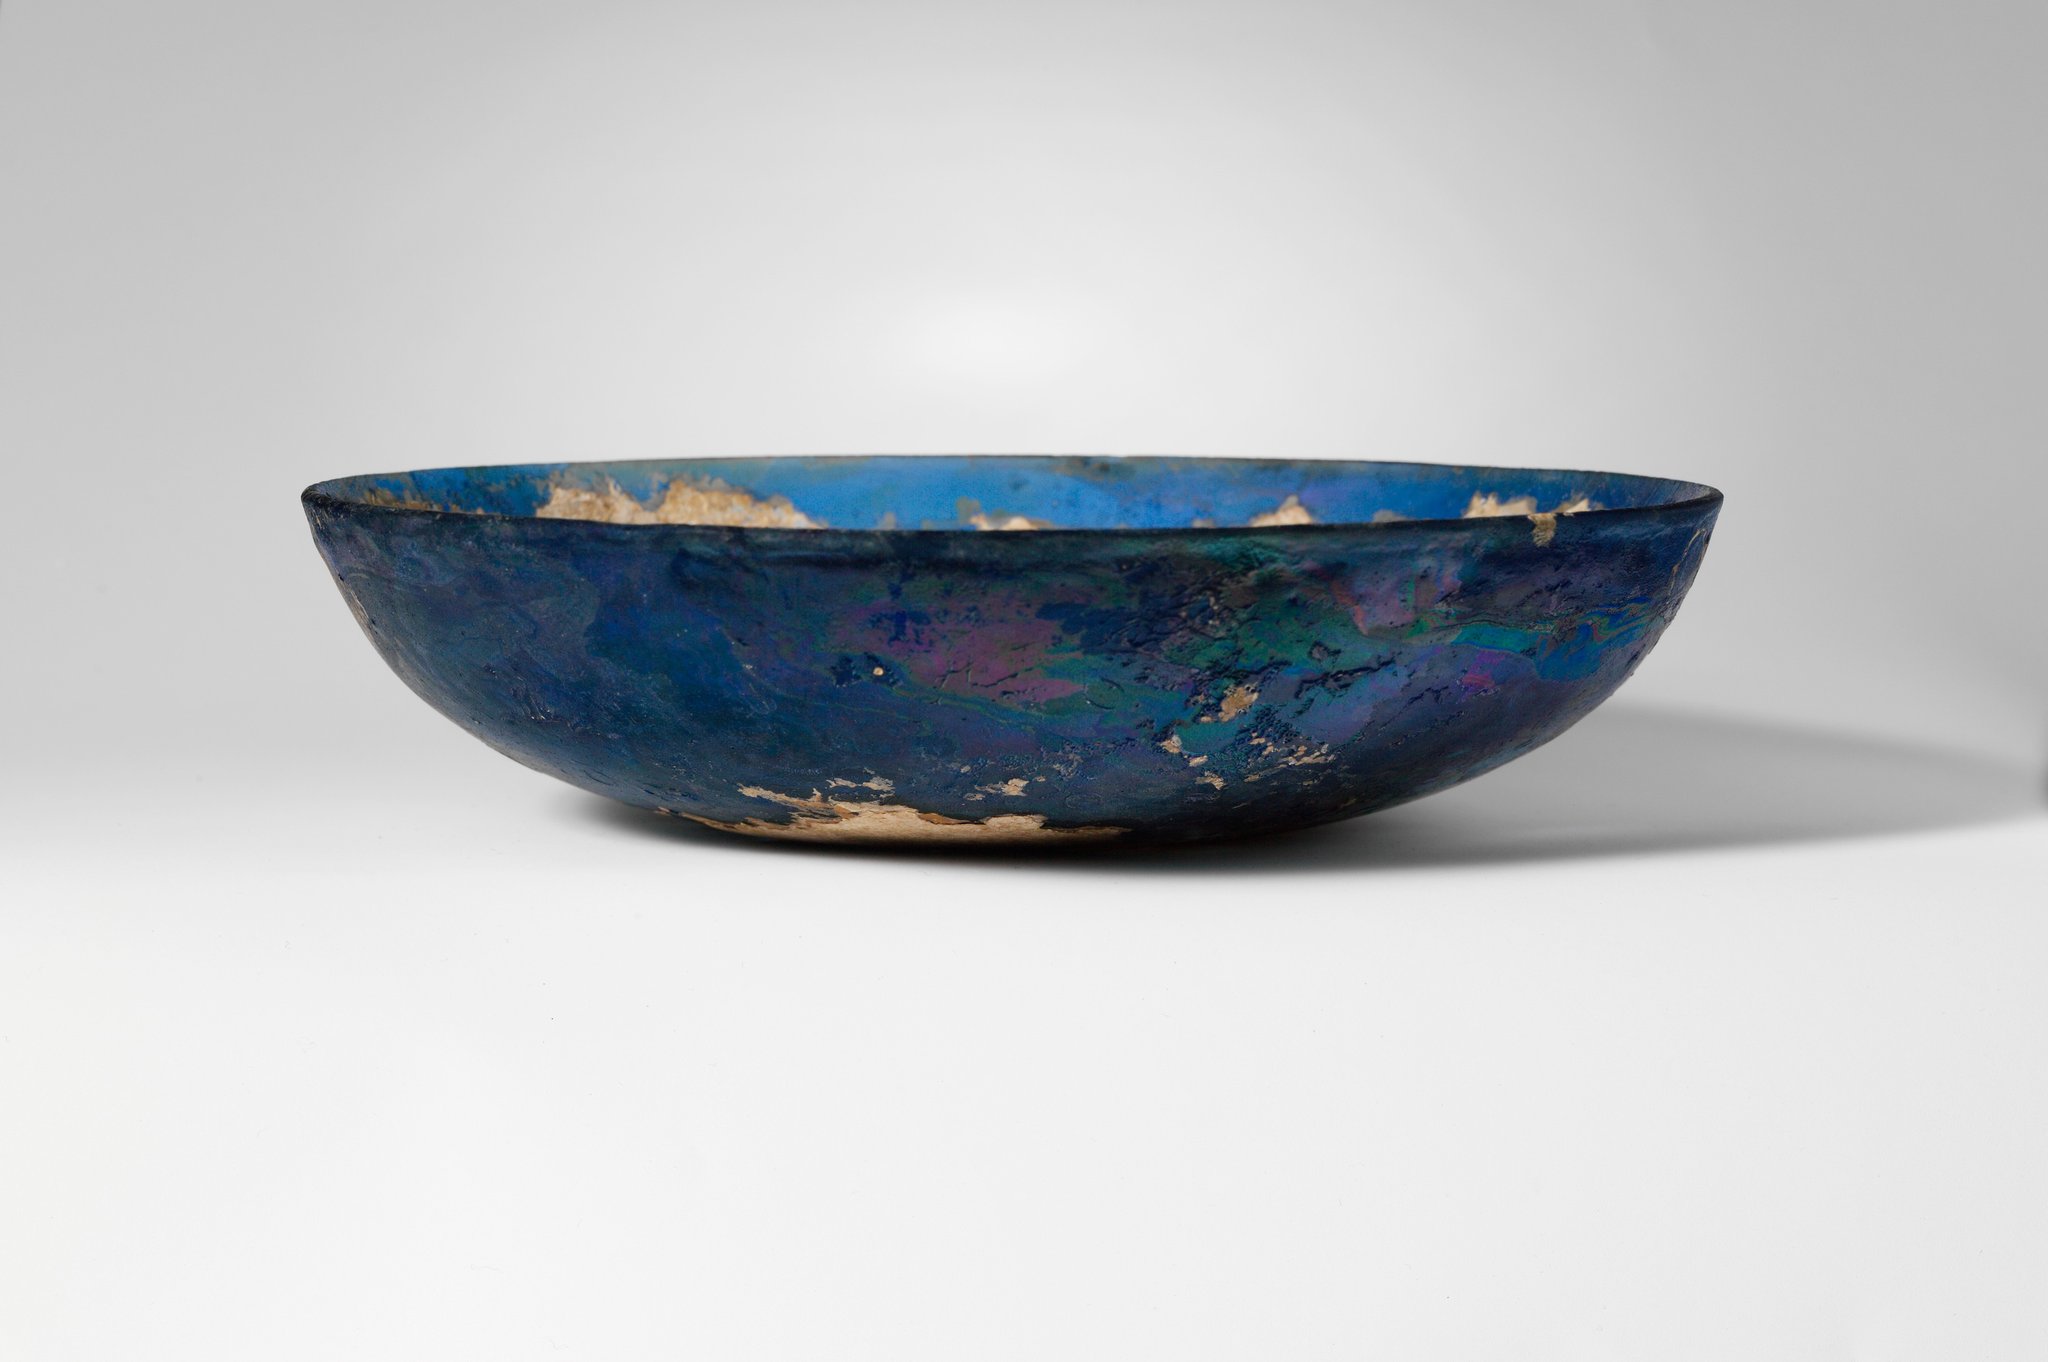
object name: bowl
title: Glass bowl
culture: roman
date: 34 BCE-33 CE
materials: glass